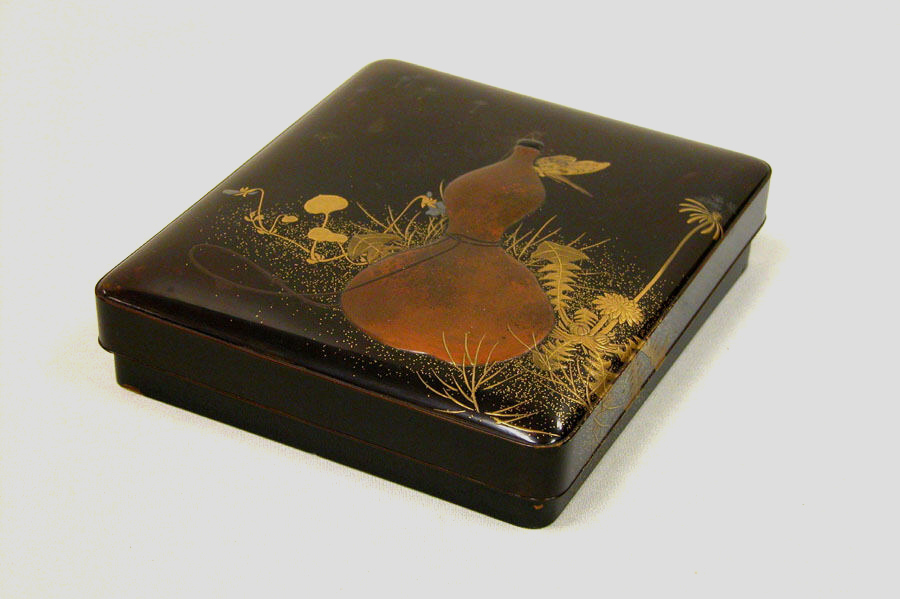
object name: writing box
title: Writing Box with Gourd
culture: japanese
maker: shibata zeshin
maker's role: artist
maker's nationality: japanese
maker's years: 1807-1891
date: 1886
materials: gold, lacquer, silver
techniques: hiramakie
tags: gourds